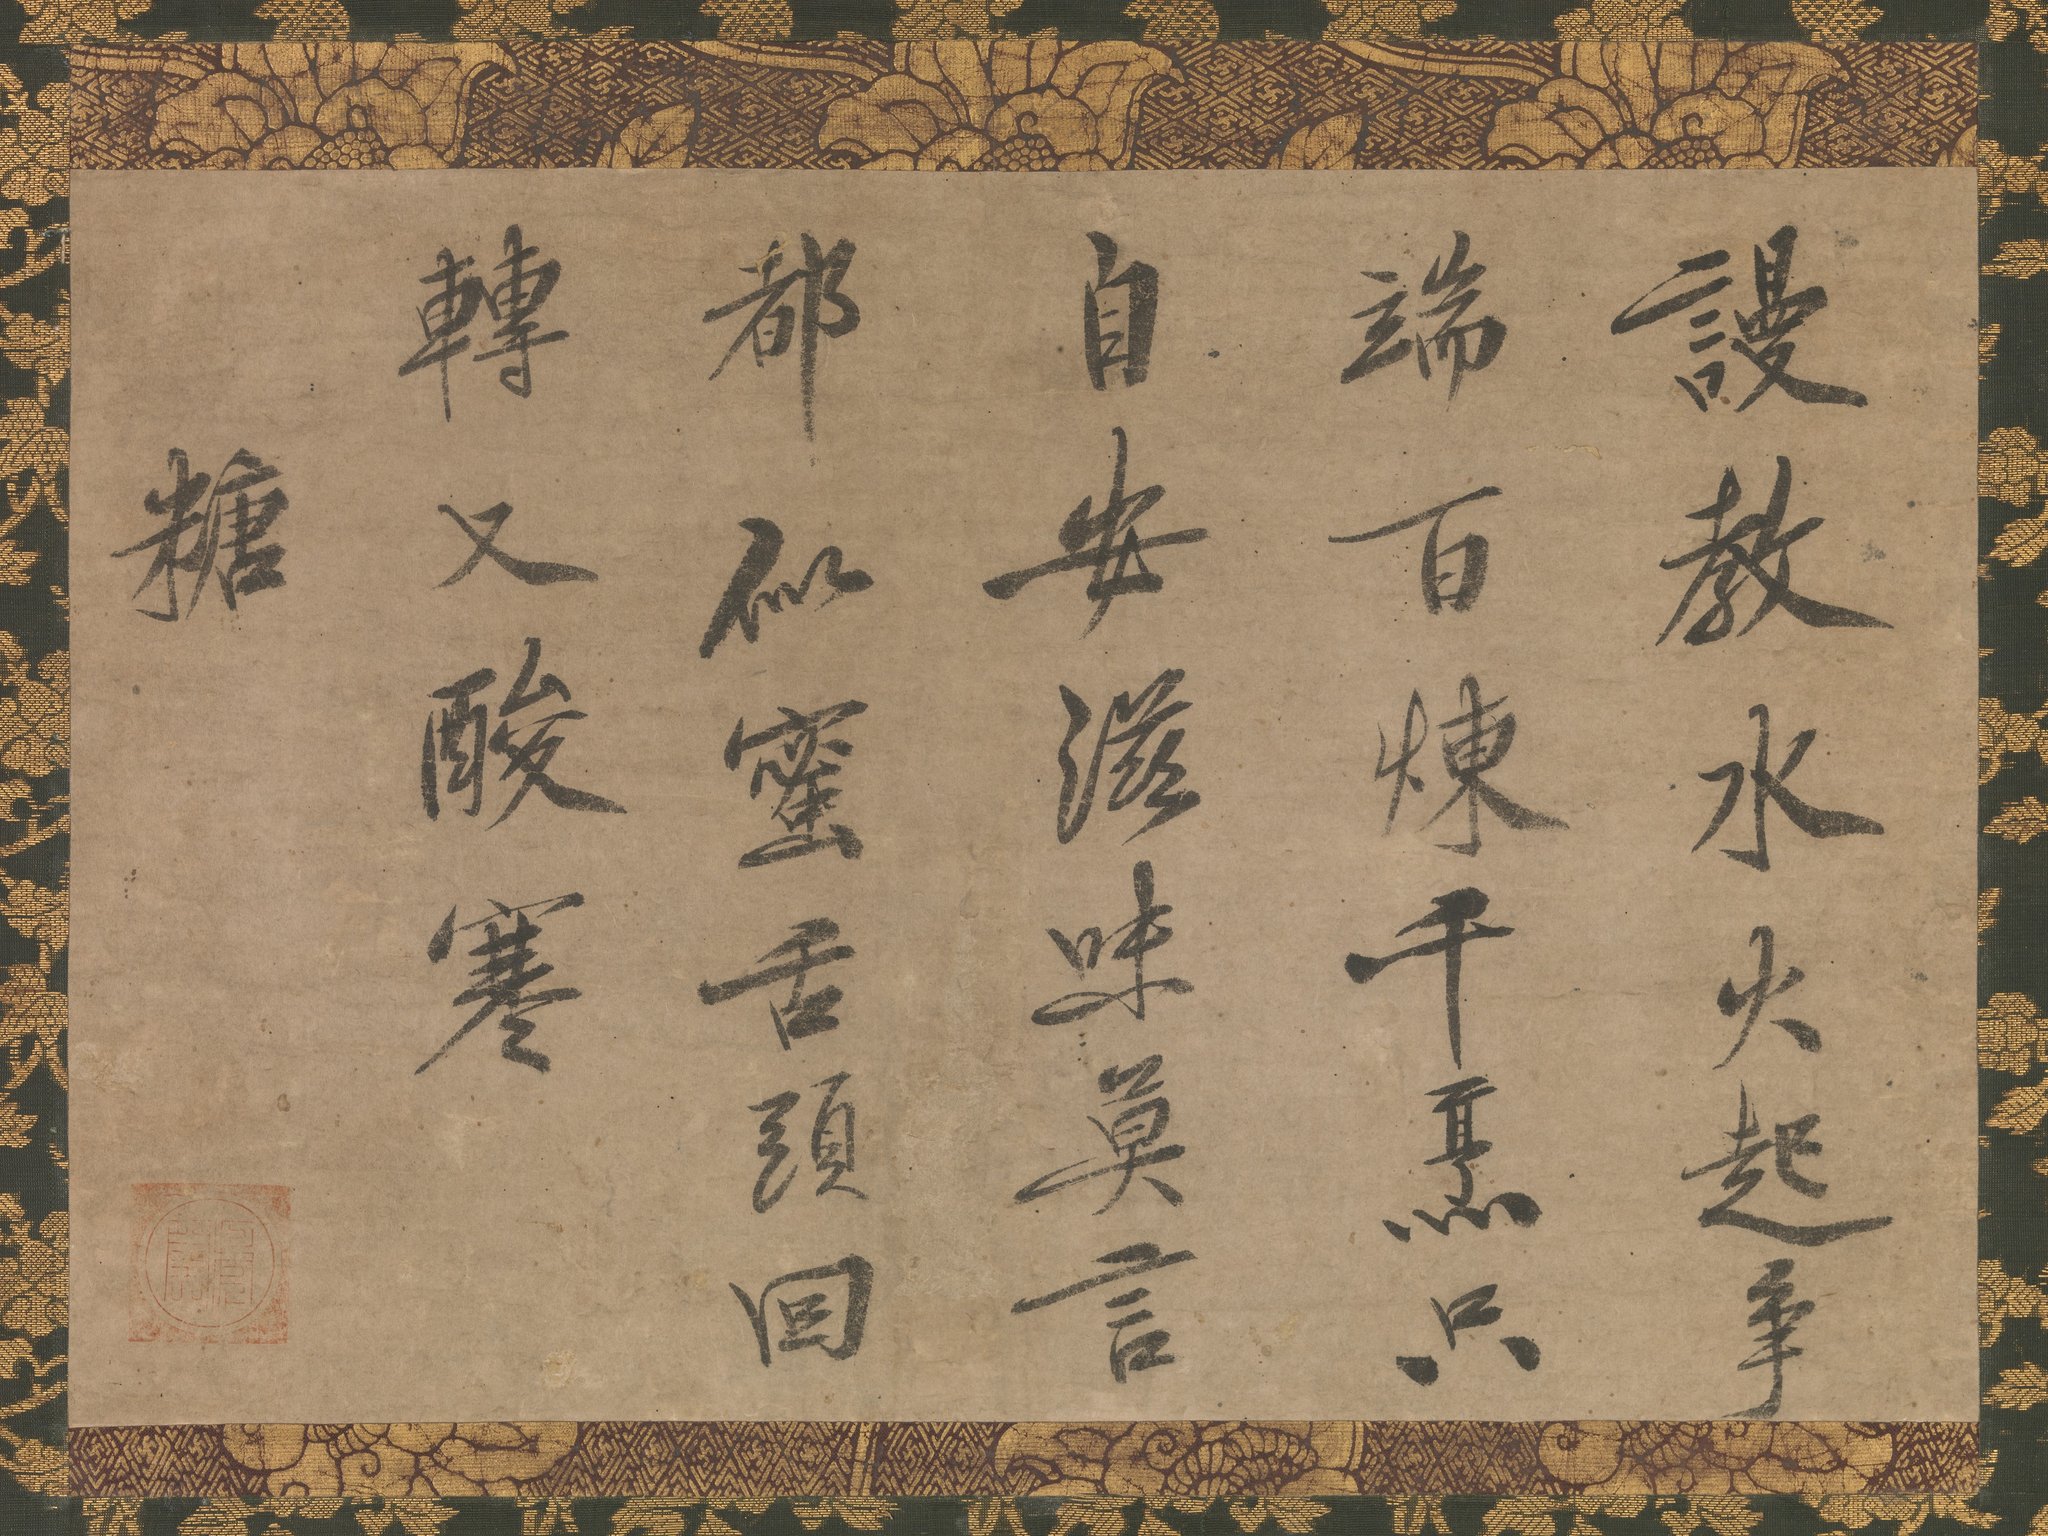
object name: hanging scroll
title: Poem in Chinese about Sugar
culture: japanese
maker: kokan shiren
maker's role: artist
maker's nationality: japanese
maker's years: 1278-1346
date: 1301-1400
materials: ink, paper